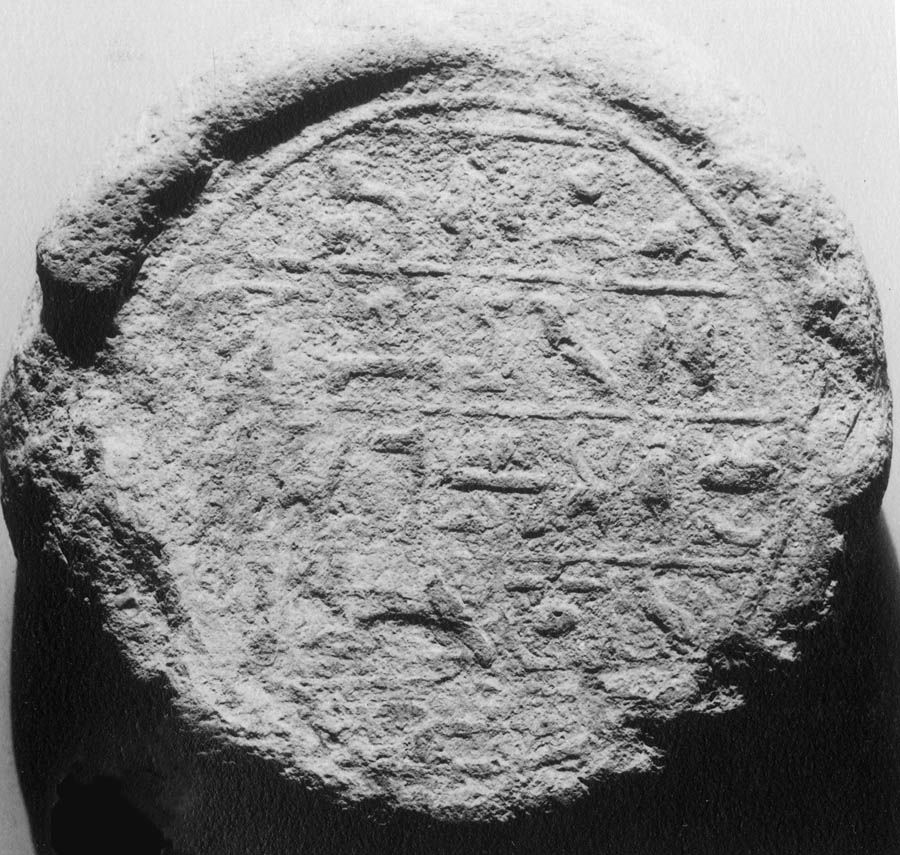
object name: cone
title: Funerary Cone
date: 1550-1295 BCE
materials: pottery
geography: egypt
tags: hieroglyphs